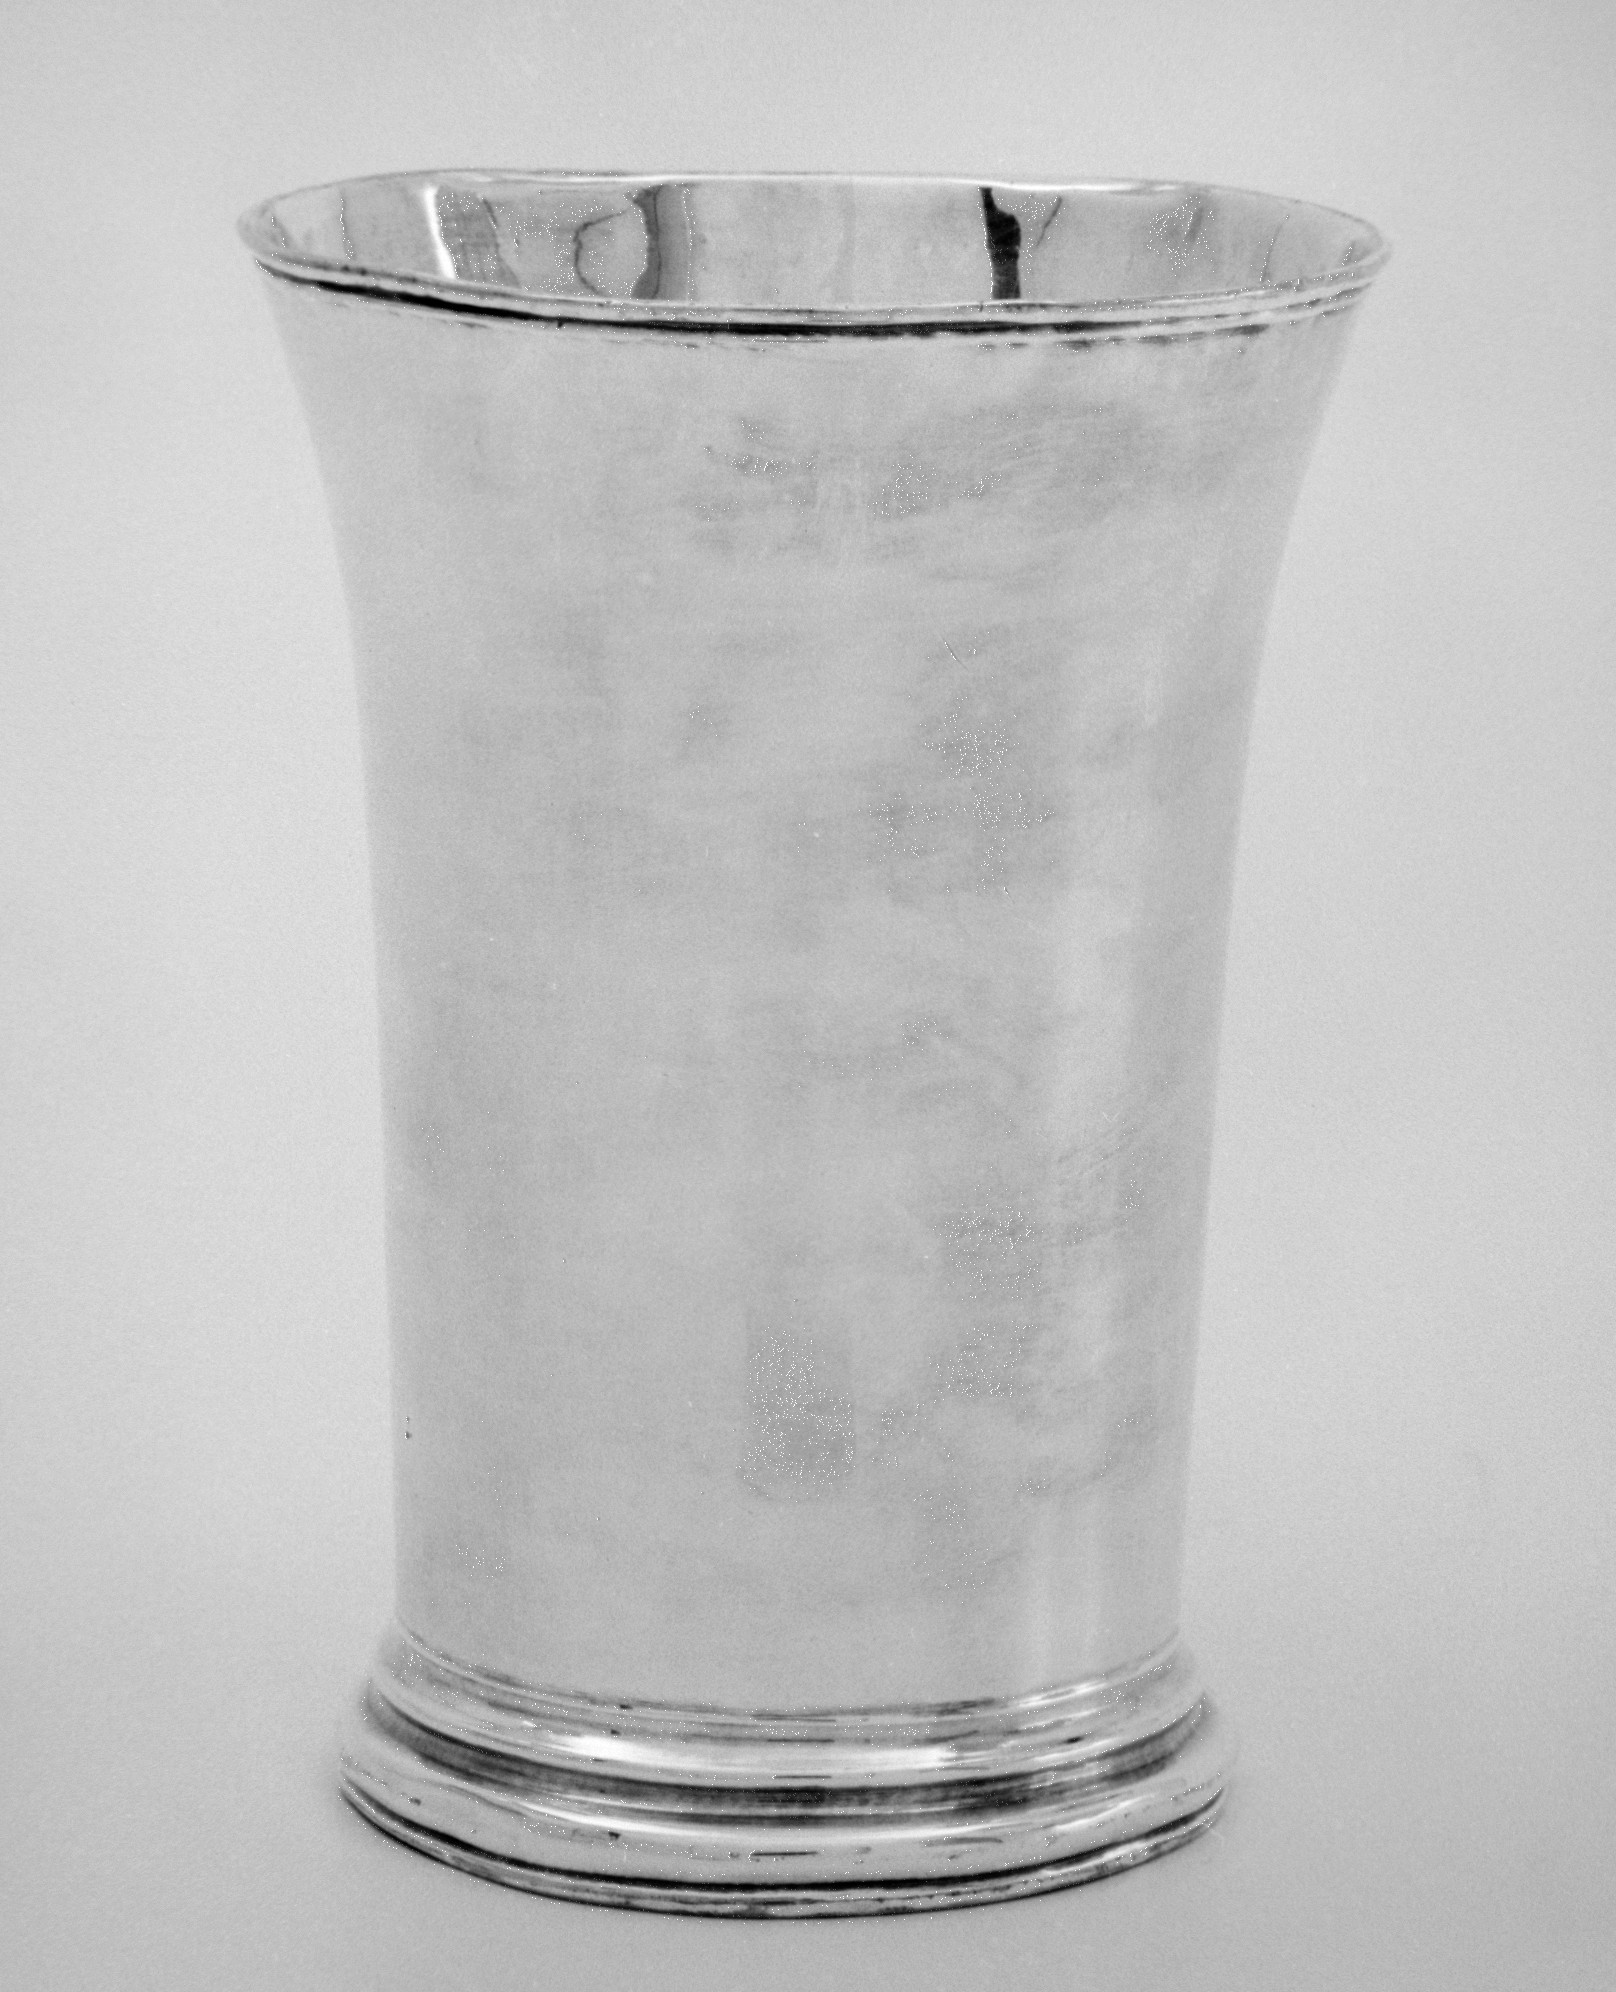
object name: beaker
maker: john hoyland and co.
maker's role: maker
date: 1764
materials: metal